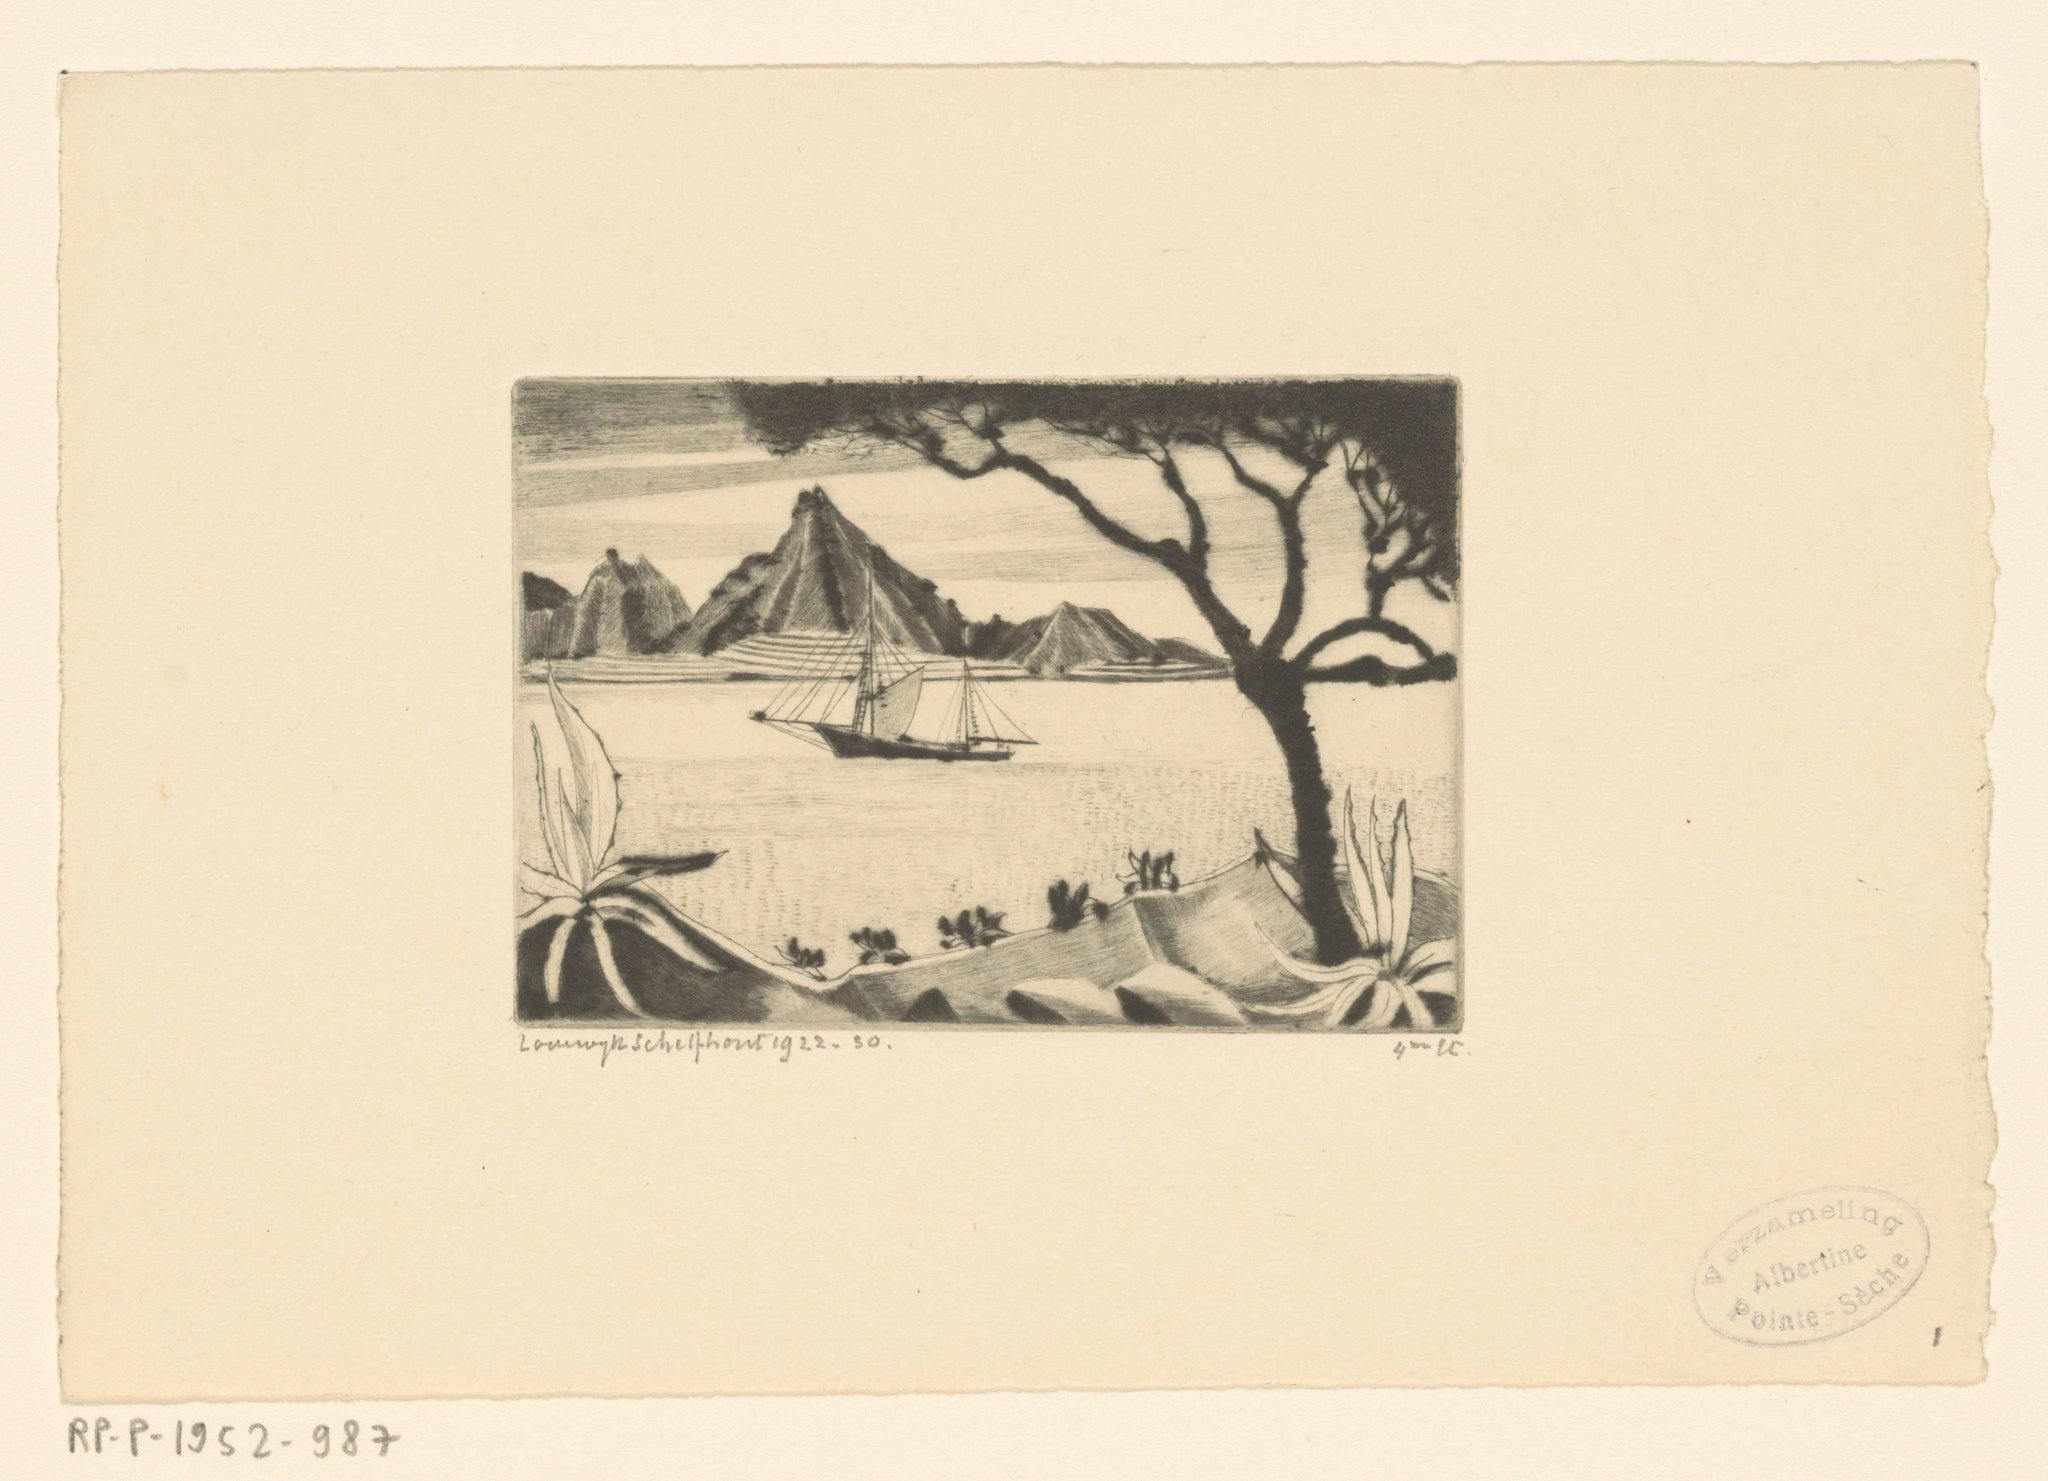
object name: print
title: Le Bâteau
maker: lodewijk schelfhout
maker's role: draughtsman, print maker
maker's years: 1881-1943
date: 1922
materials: paper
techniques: drypoint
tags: sailing-ship, sailing-boat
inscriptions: collector's mark: Lugt 5i, collector's mark: Lugt 2760, collector's mark: Lugt 2228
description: Op de voorgrond een boom, op de achtergrond bergen.